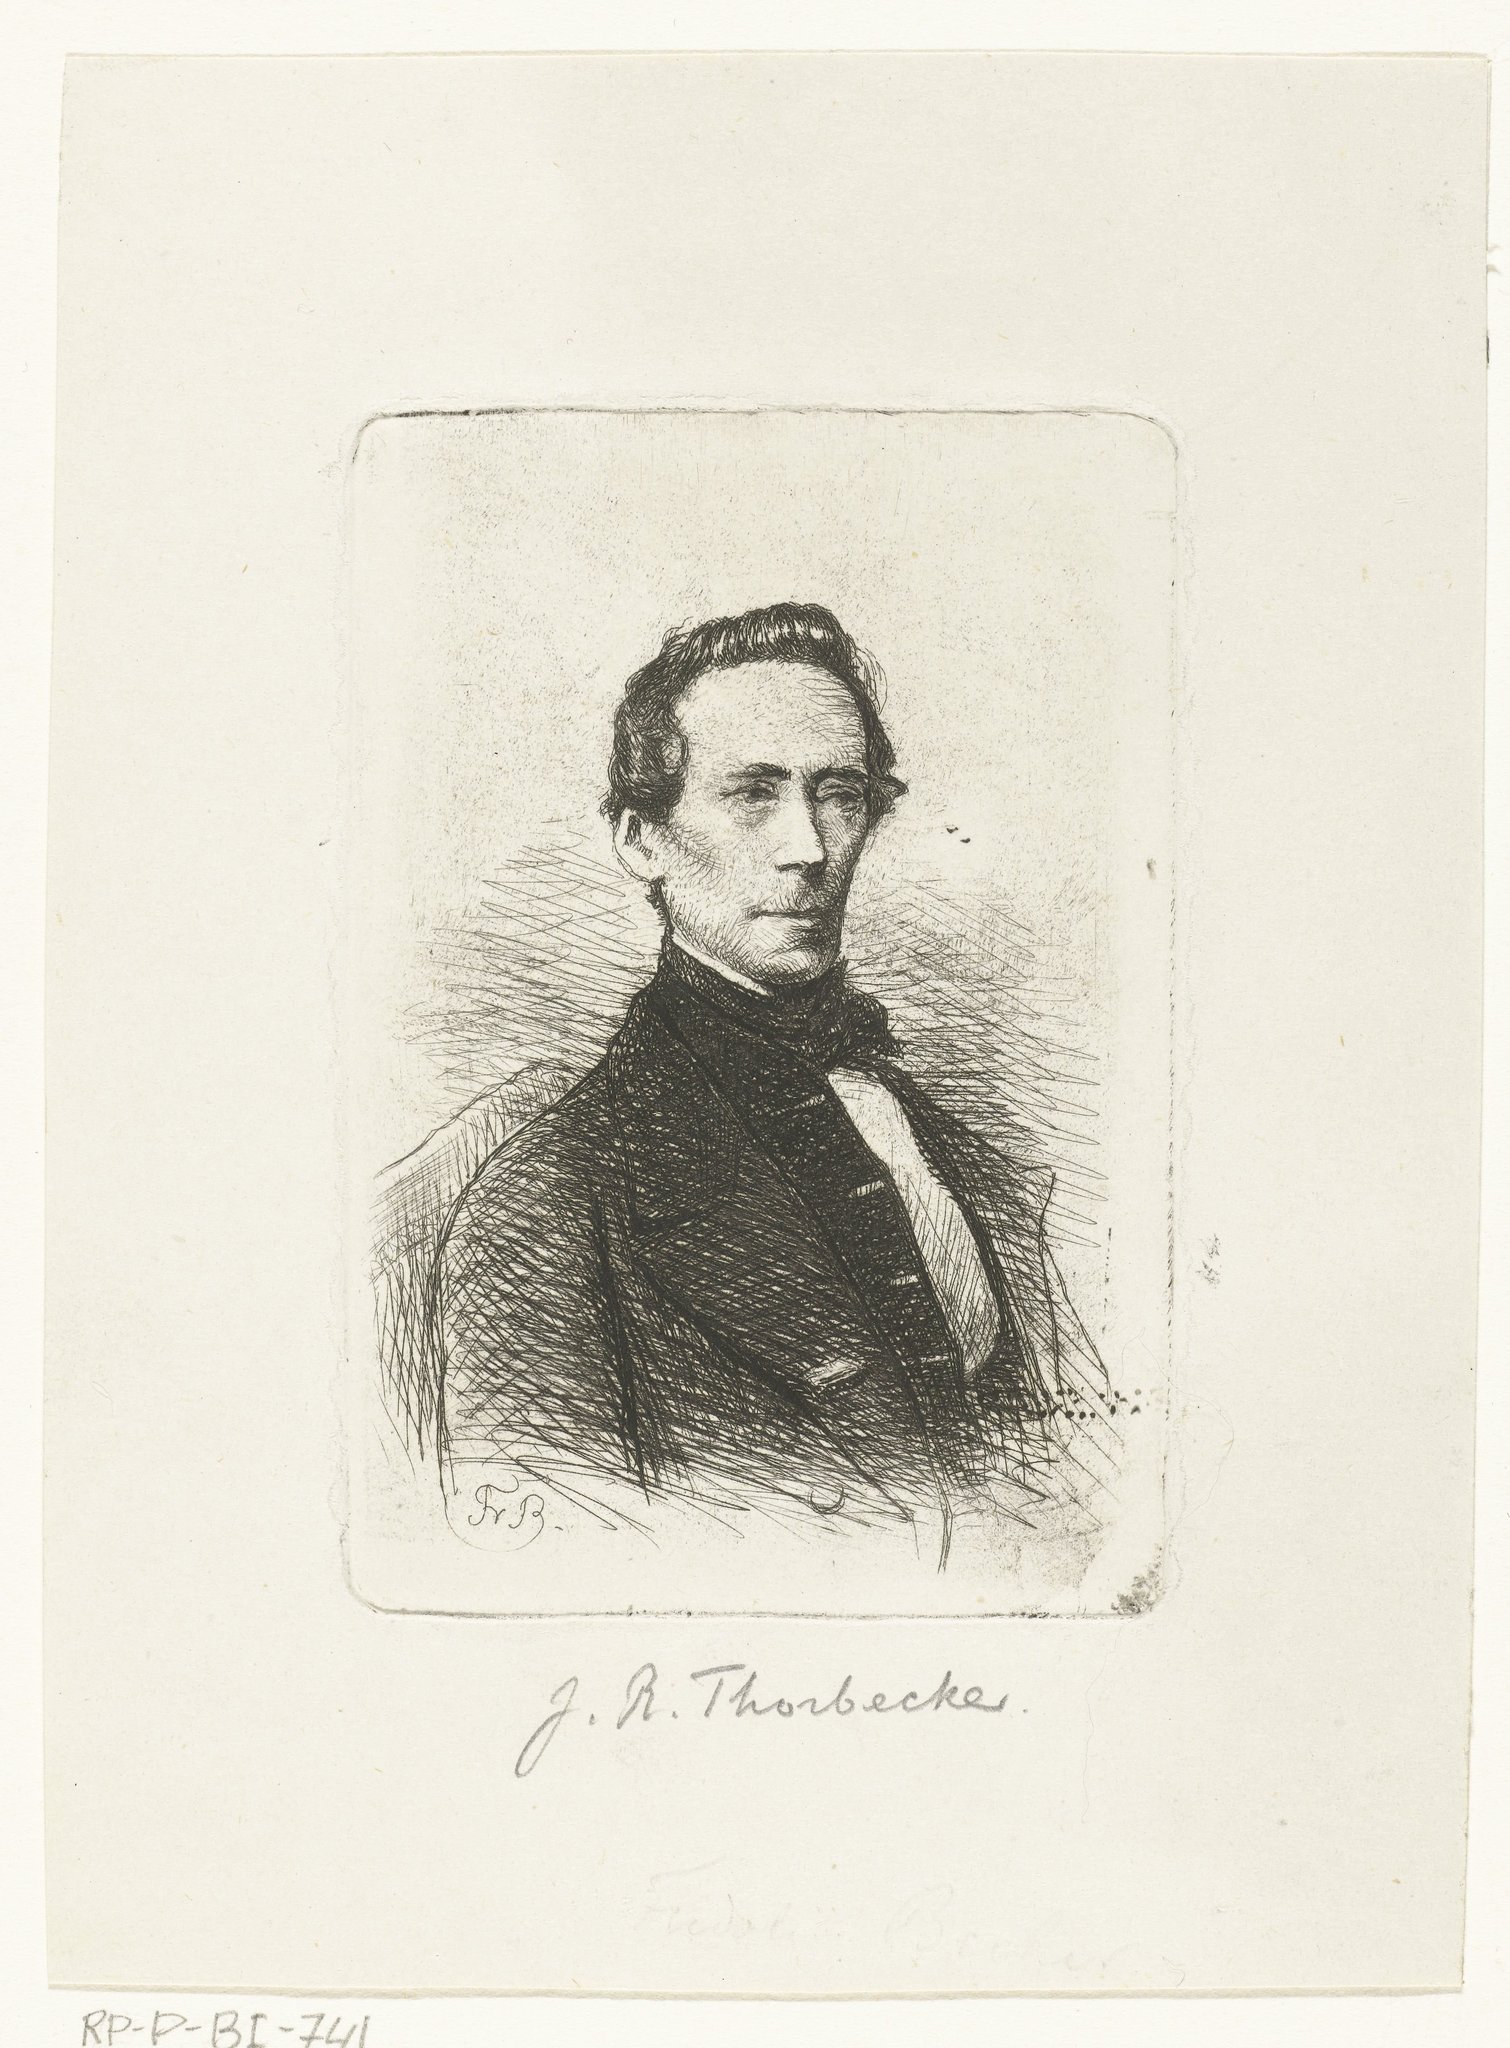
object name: print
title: Portret van Johan Rudolf Thorbecke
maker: fridolin becker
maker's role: print maker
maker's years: 1830-1895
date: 1840-1895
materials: paper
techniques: etching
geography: netherlands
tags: johan rudolf thorbecke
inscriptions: collector's mark: Lugt 2228